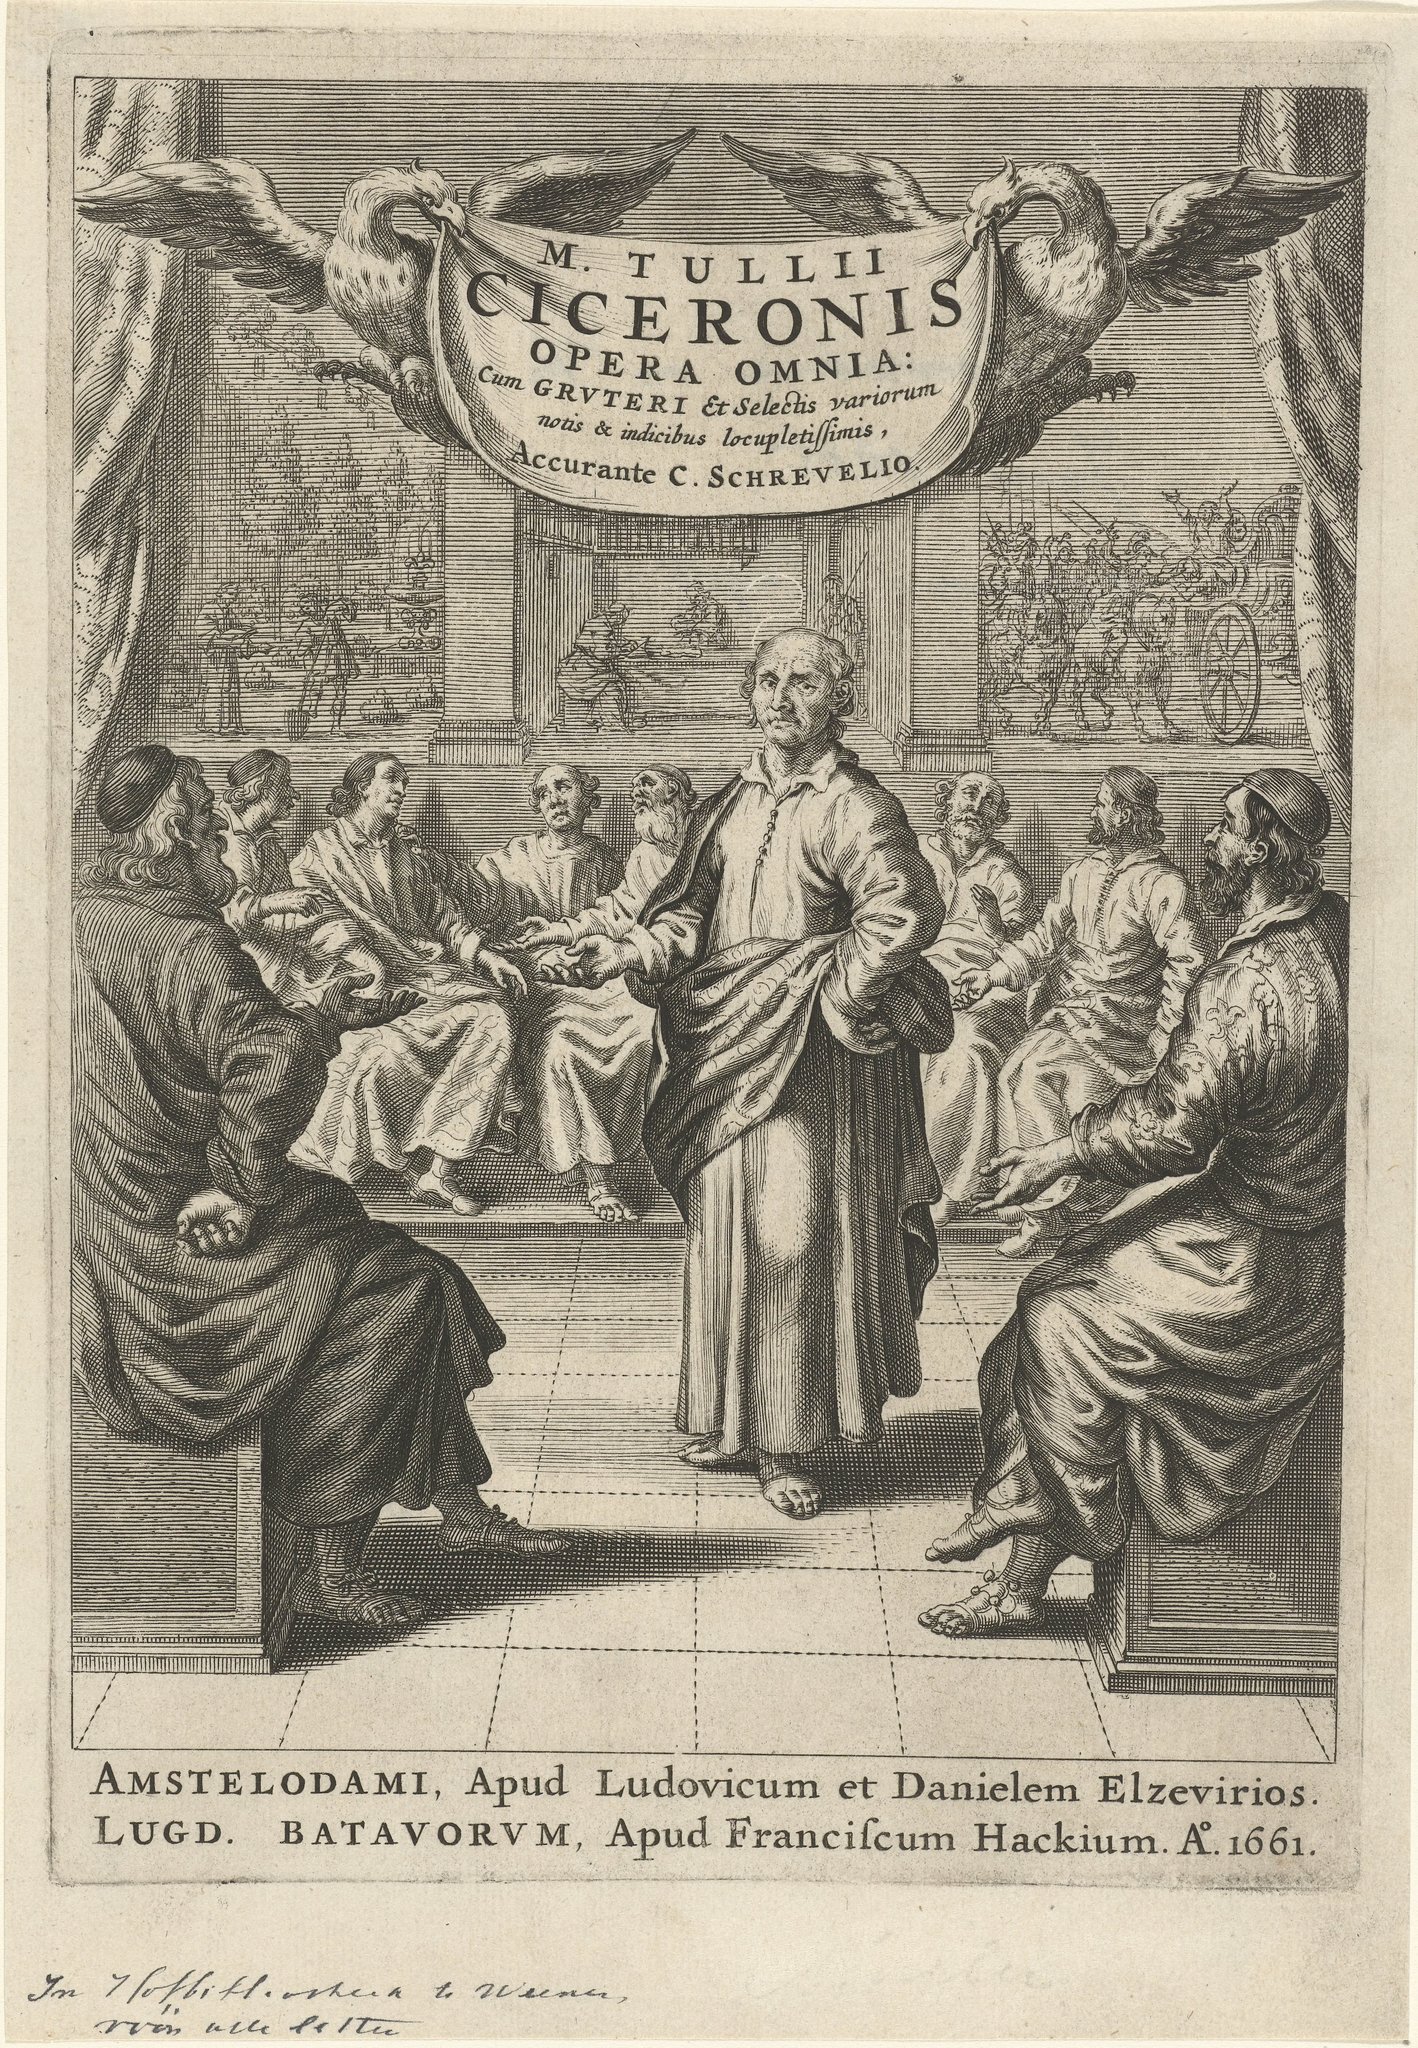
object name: print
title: Cicero en discussiërende figuren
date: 1661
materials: paper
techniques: engraving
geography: amsterdam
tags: marcus tullius cicero, debate, discussion (~ meeting)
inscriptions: collector's mark: Lugt 2228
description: Titelpagina voor: Cicero, Marcus Tullius. [bewerkt door] I. Gruterus en C. Schrevelius. Opera omnia. Amsterdam: Daniel en Lowijs III Elsevier en Leiden: Franciscus Hackius, 1661.